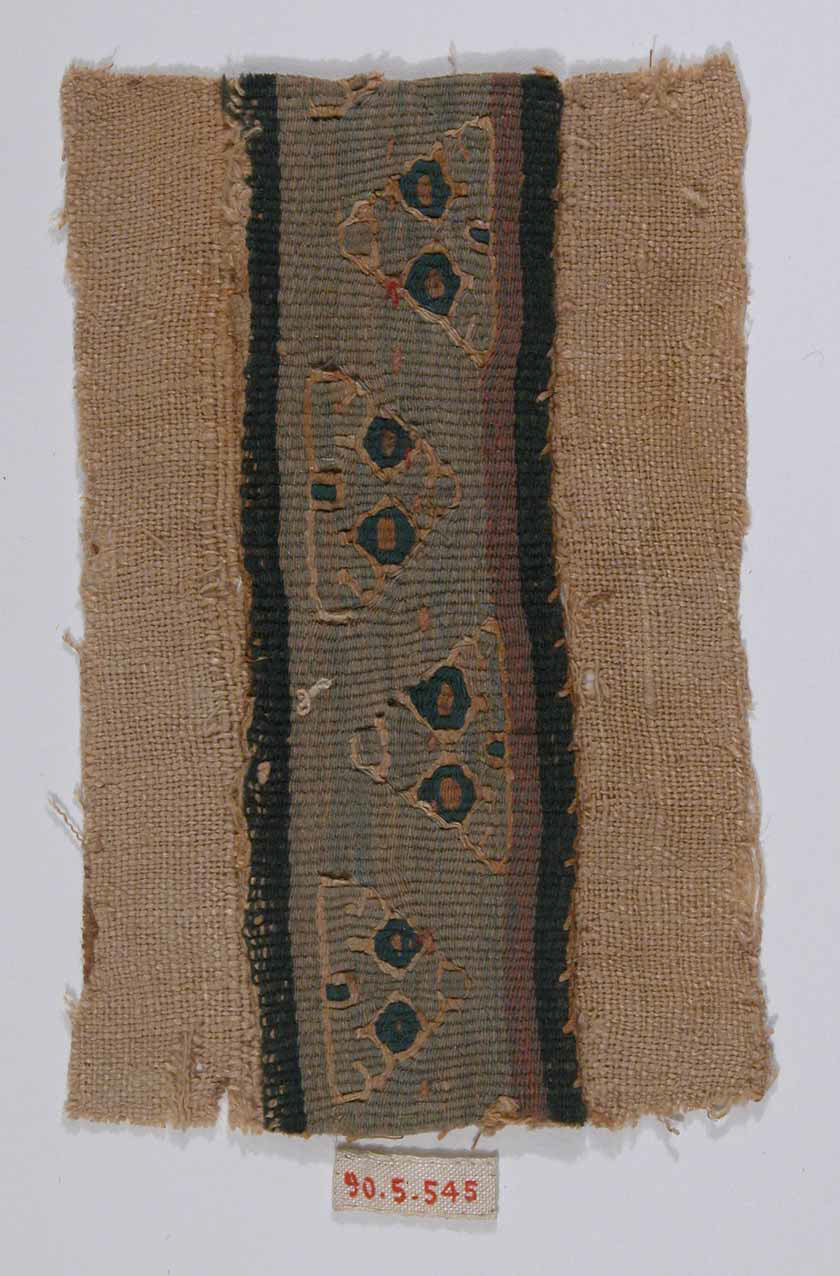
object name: textile fragment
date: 401-600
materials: linen, wool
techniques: weave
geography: egypt